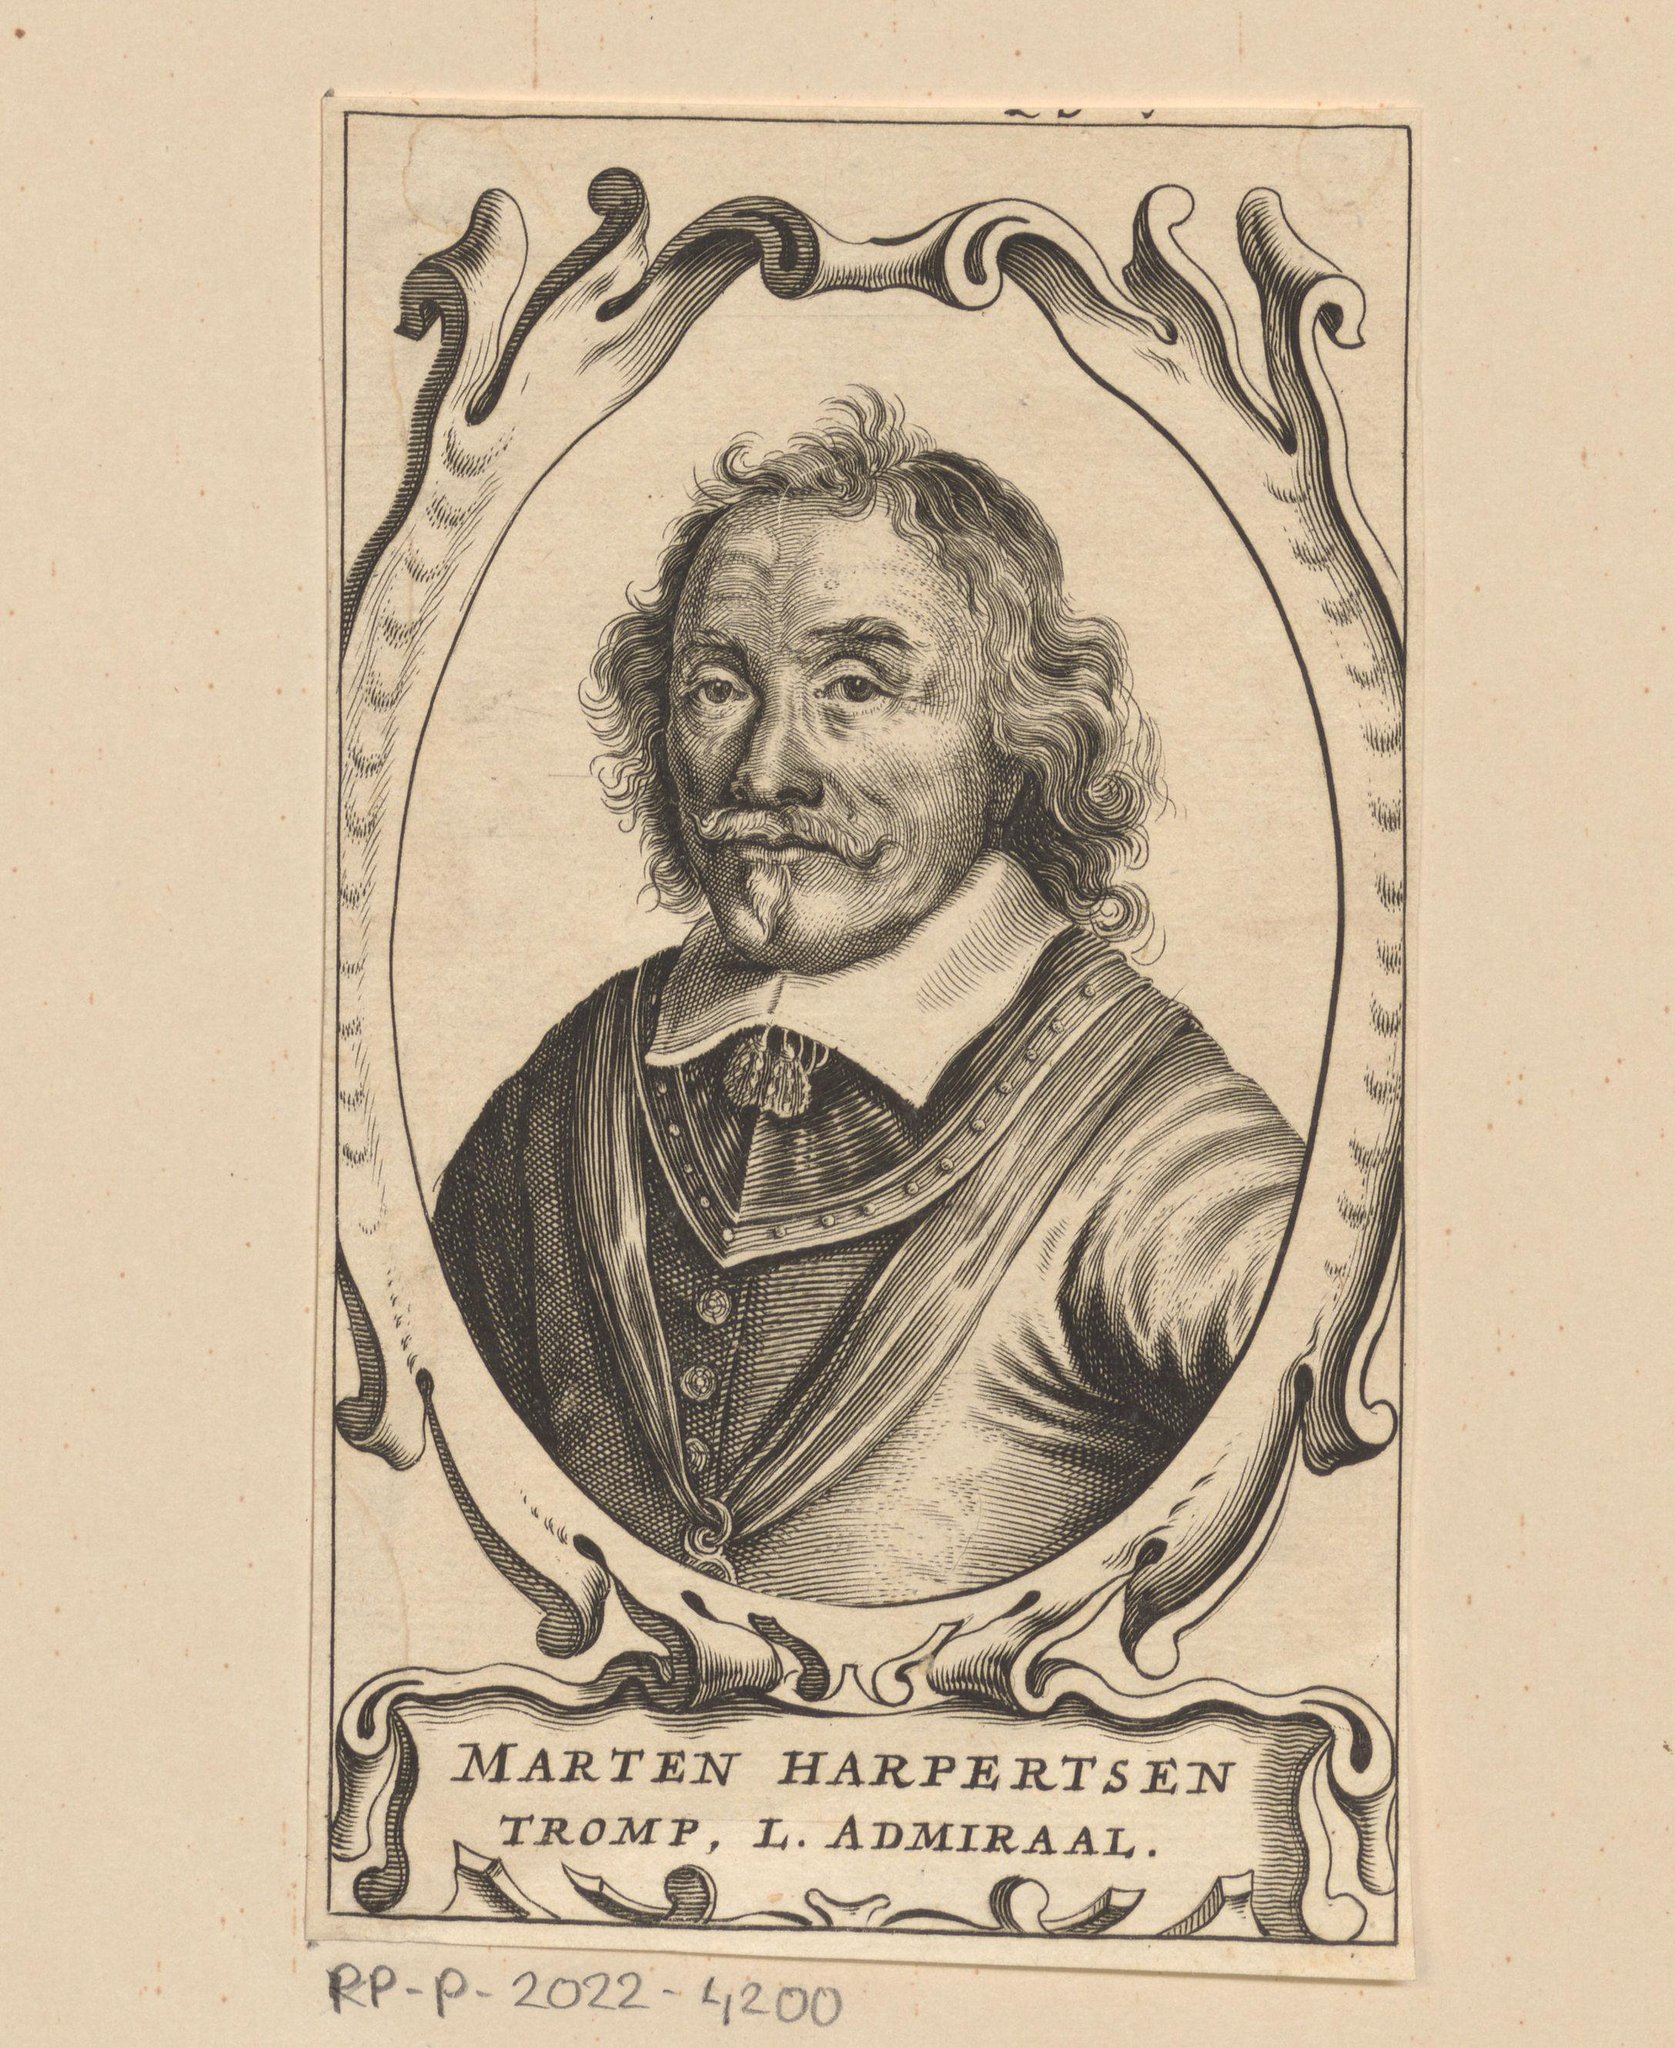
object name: print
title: Portret van Maarten Harpertszoon Tromp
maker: Anonymous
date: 1663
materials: paper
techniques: engraving, etching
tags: maarten harpertszoon tromp, historical persons, commander-in-chief, admiral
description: Prent waarschijnlijk uit: Nassouser heldens pronk-toonneel (...). Amsterdam: Jacob van Meurs en Steeven van Lier, 1663, dl. 2, p. 428.